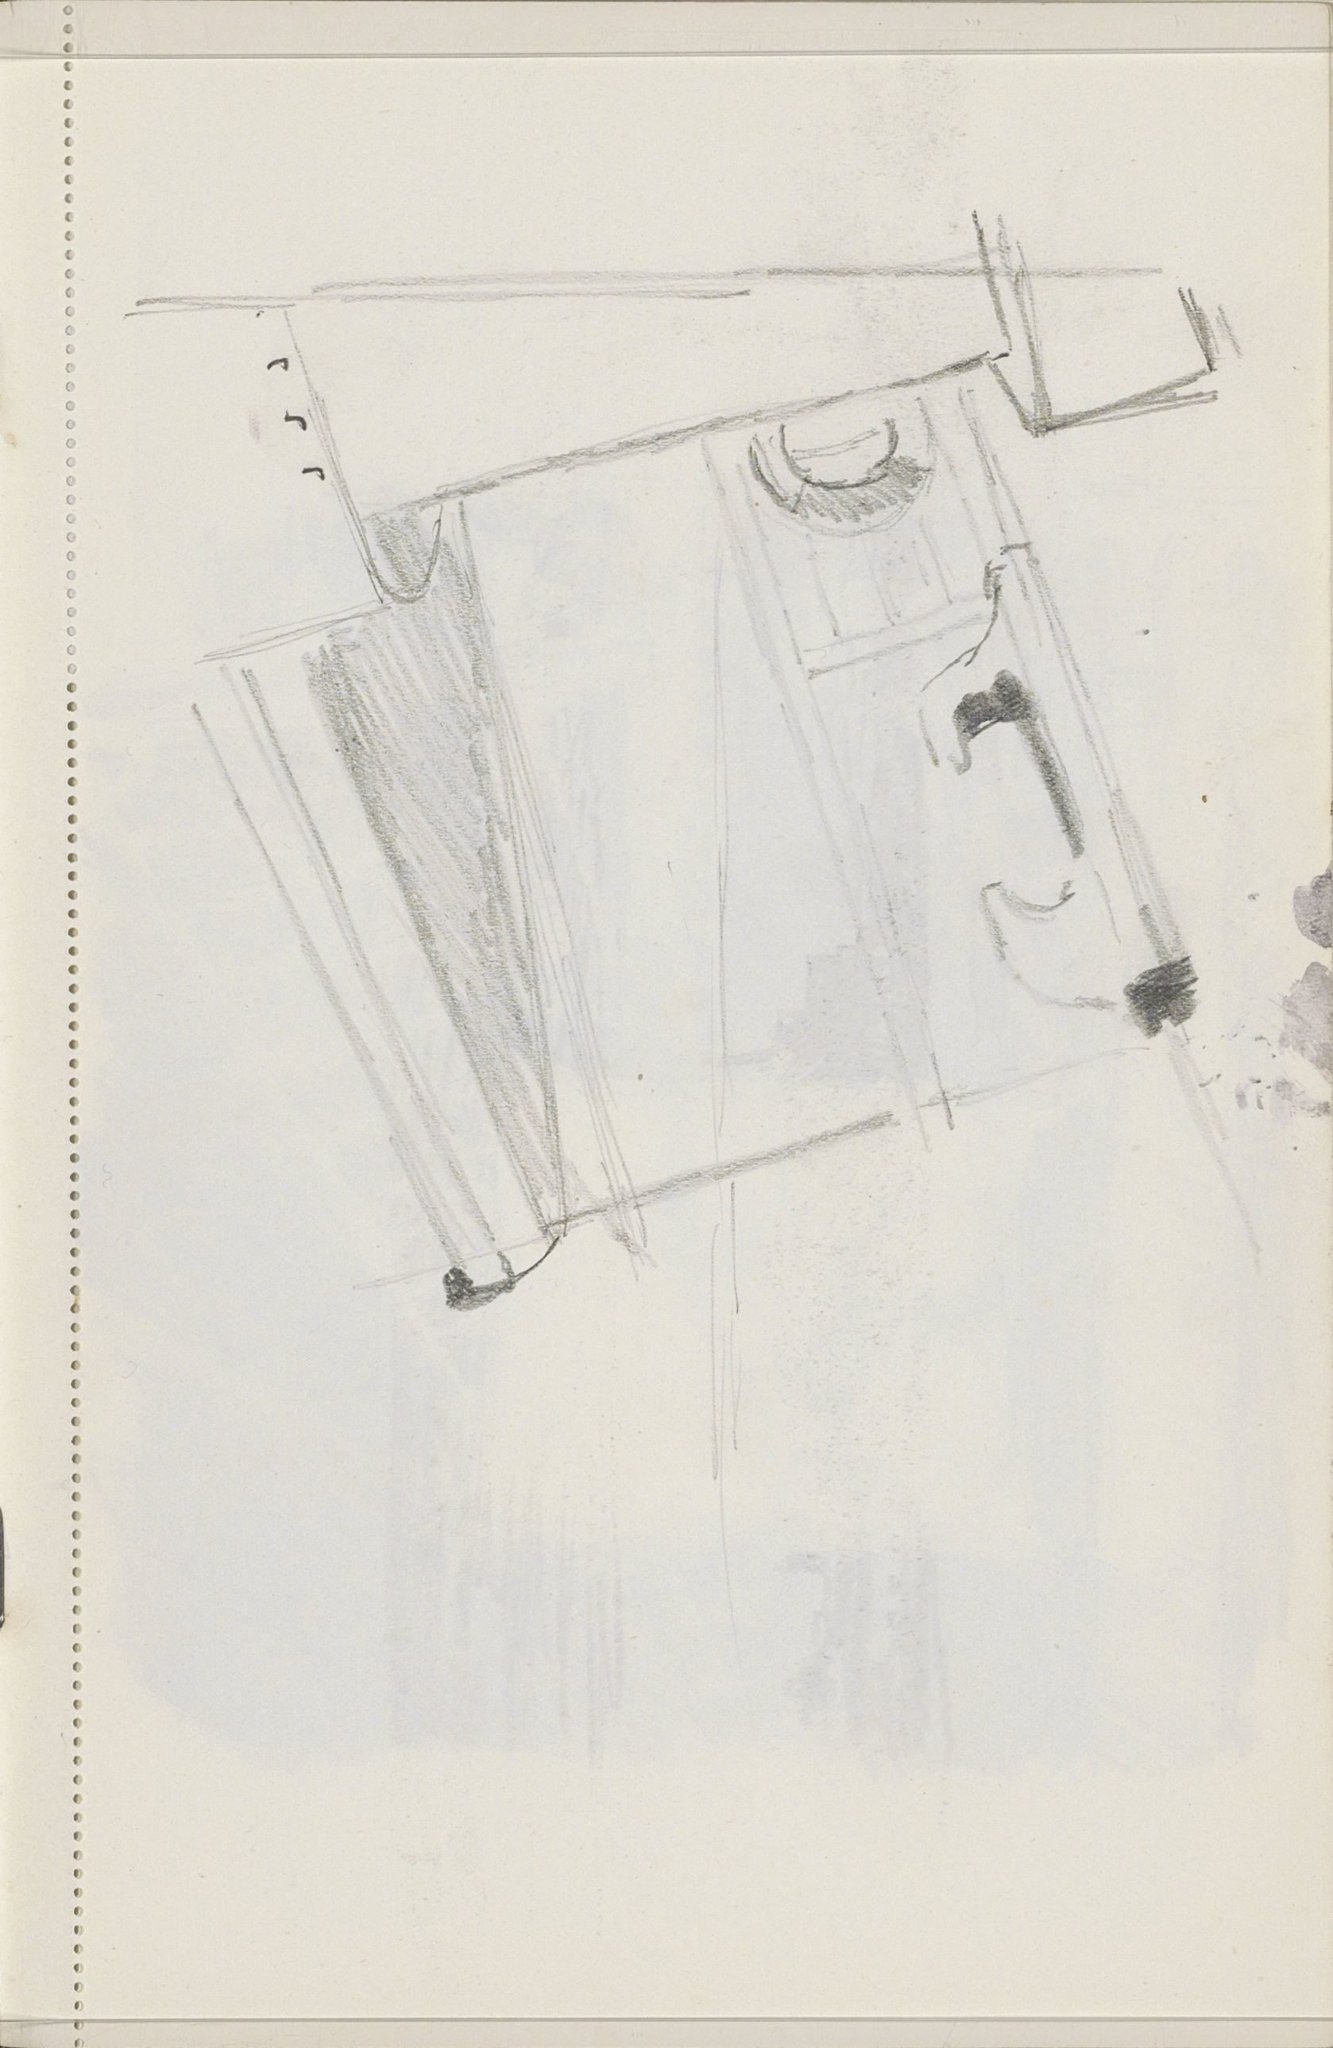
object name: sketchbook leaf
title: Deel van het exterieur van een schip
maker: cornelis vreedenburgh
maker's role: draughtsman, print maker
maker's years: 1880-1946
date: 1936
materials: paper, pencil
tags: parts of ship's exterior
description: Onder andere een trap en een reddingsboei. Blad 24 recto uit een schetsboek met 73 bladen.